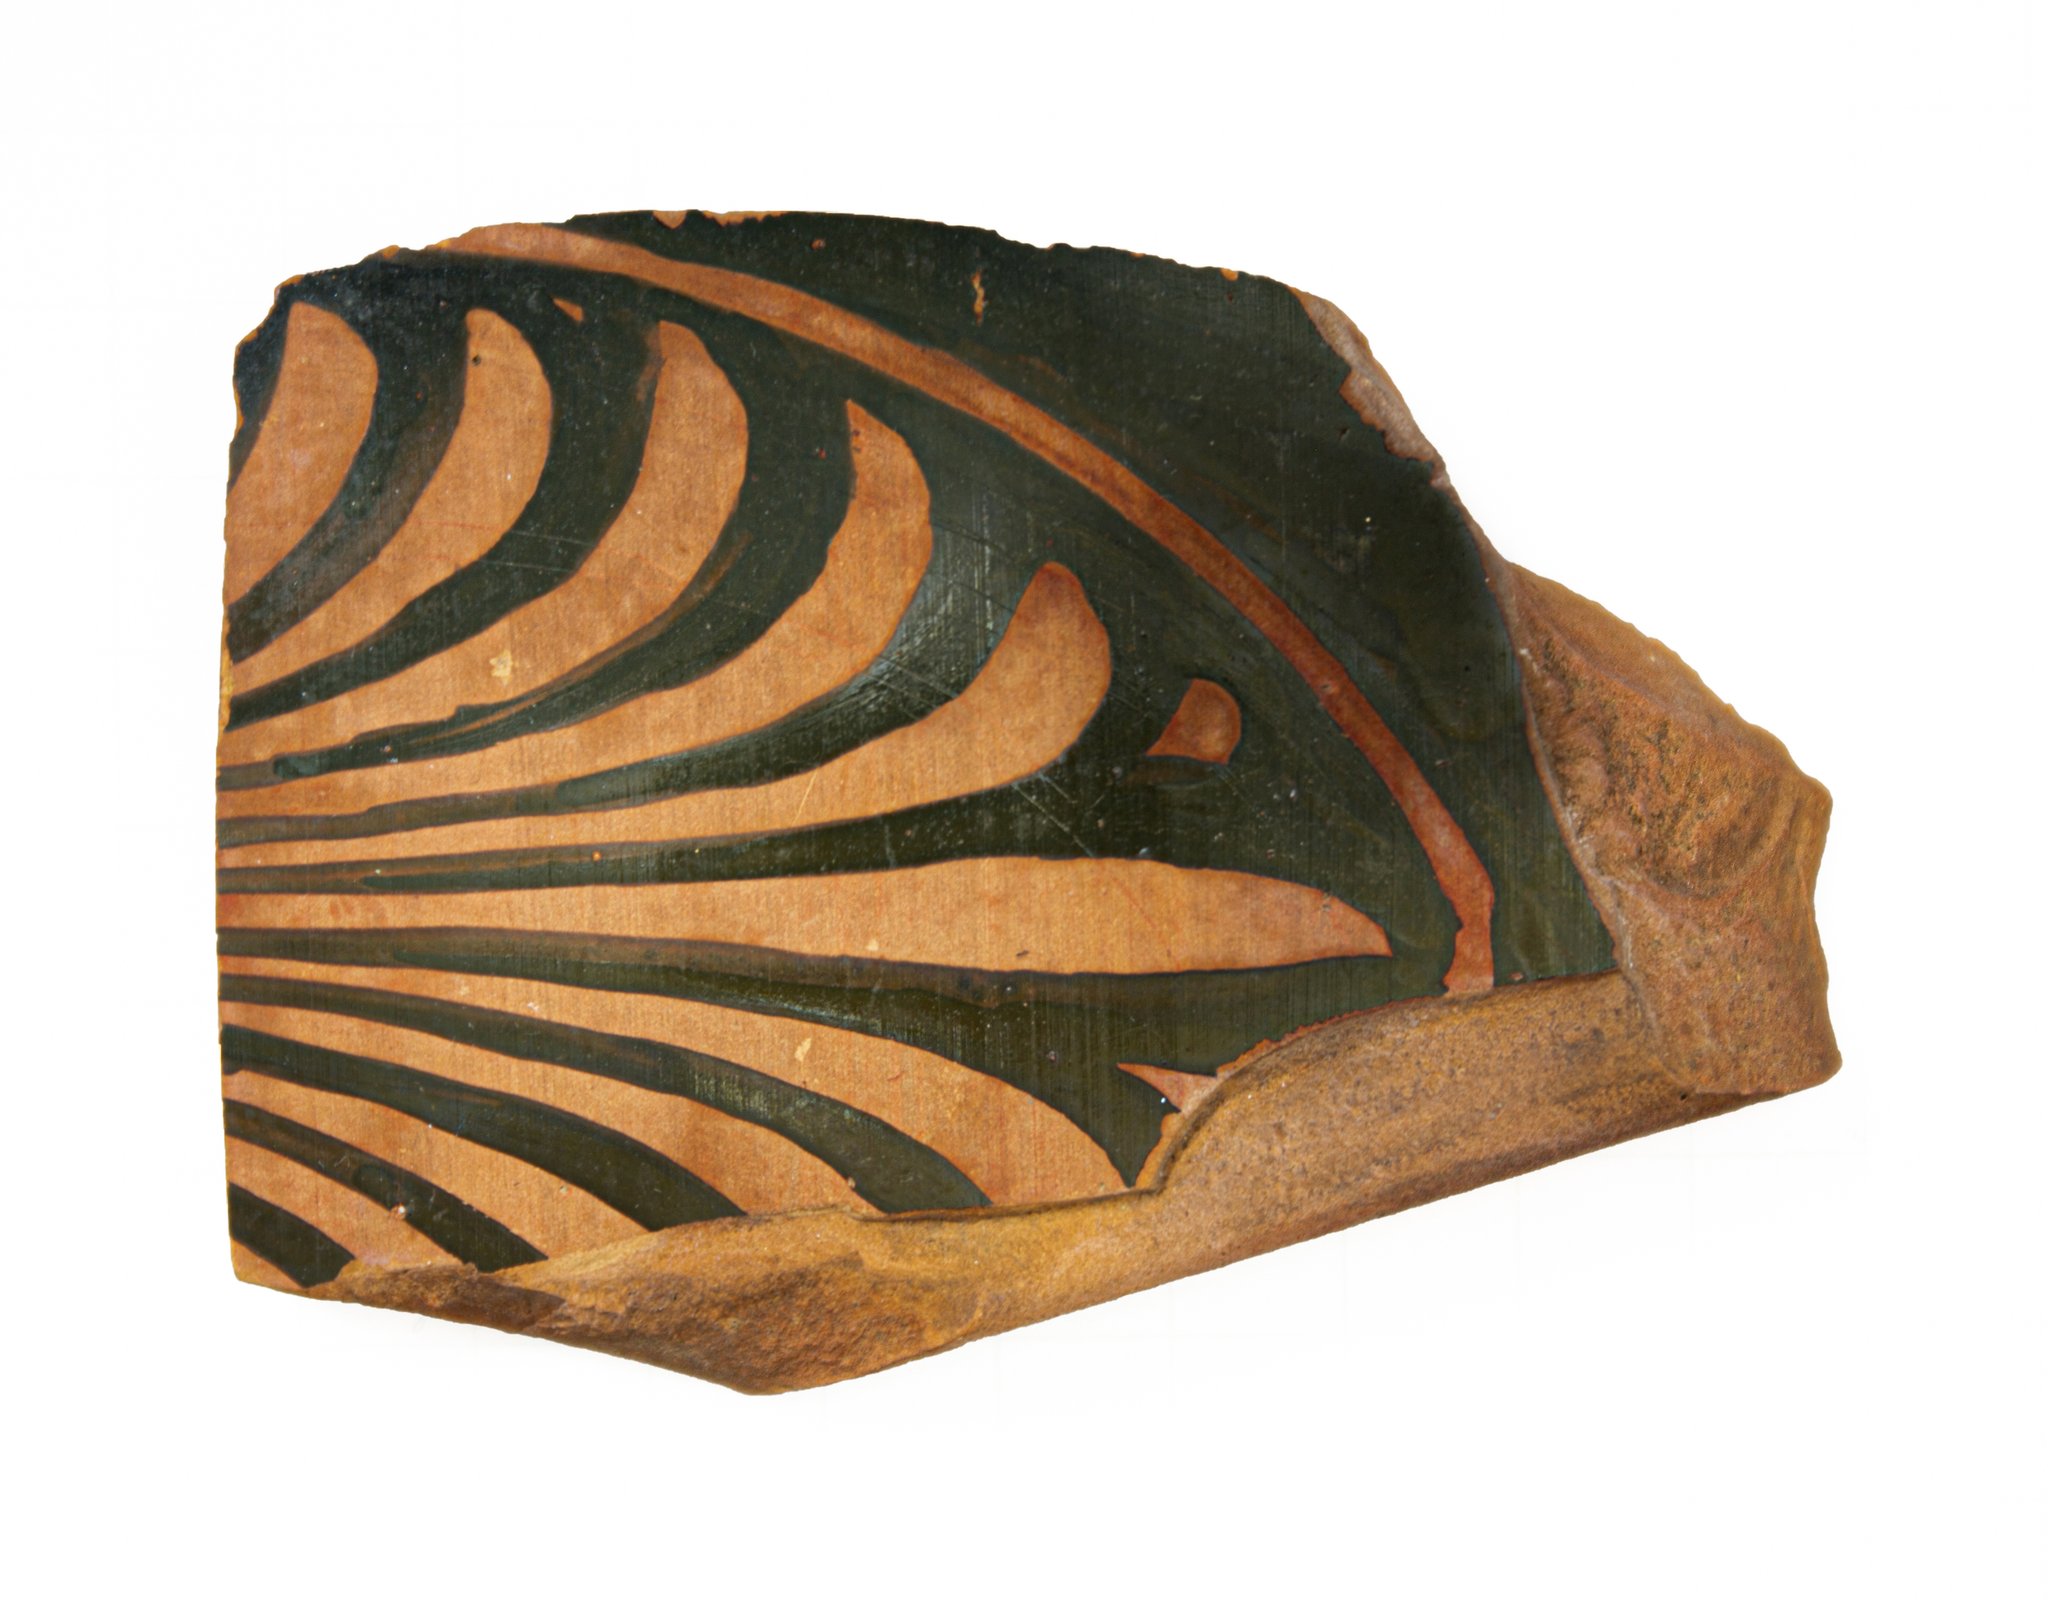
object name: volute krater fragment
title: Volute-krater fragment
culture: greek, south italian, apulian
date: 400-301 BCE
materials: terracotta